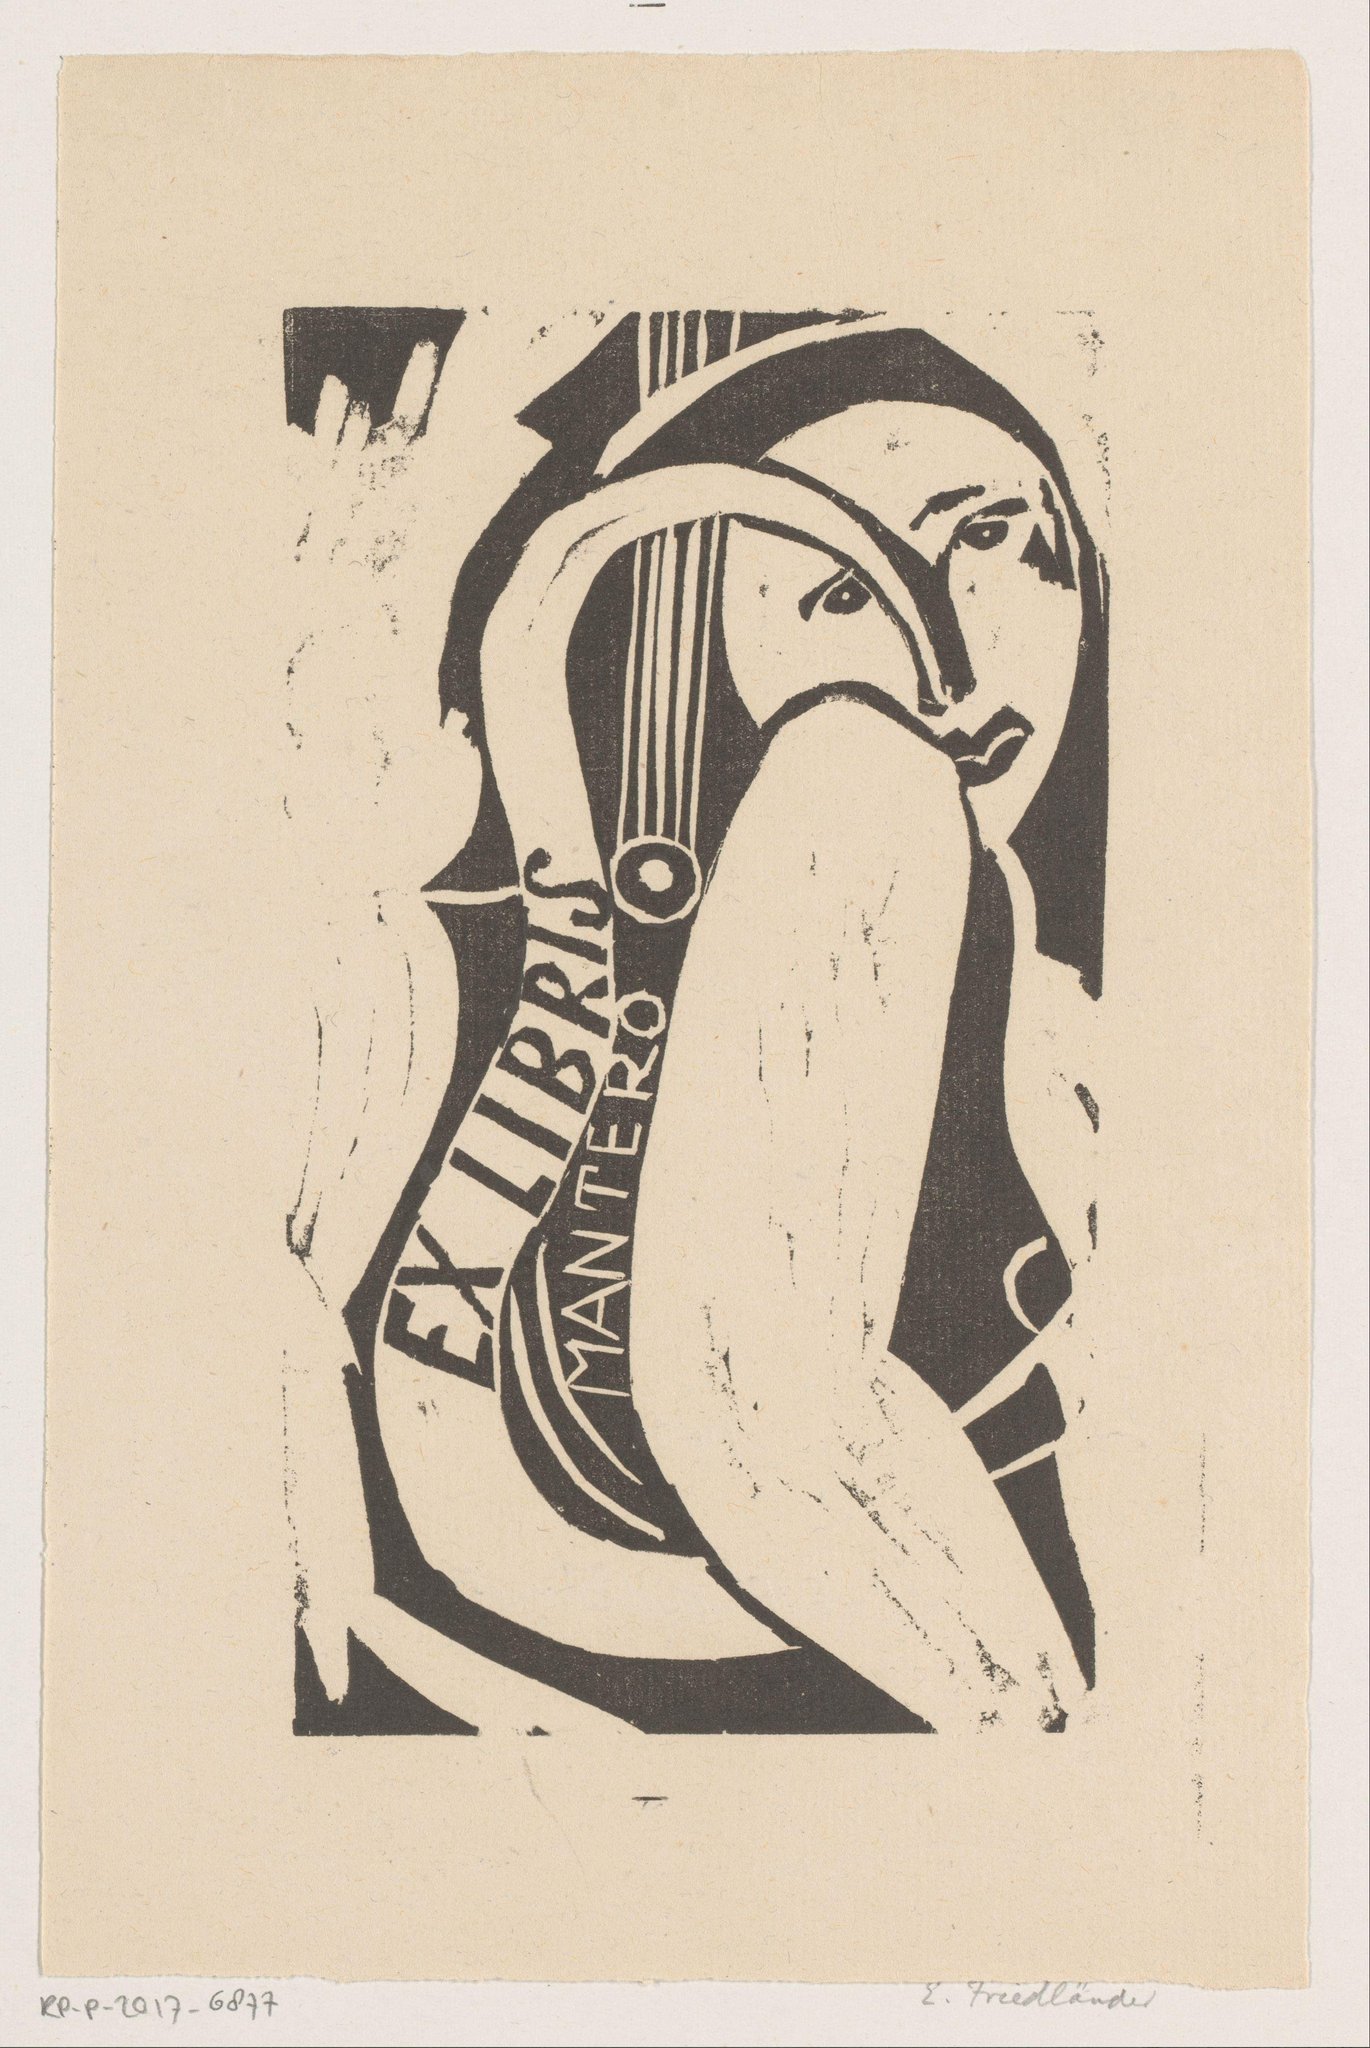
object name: bookplate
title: Ex libris van Gianni Mantero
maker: erna levy friedländer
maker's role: print maker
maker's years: 1890-1979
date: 1907-1985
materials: paper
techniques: woodcut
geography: germany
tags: gianni mantero, adult woman, cithern, mandolin, guitar, balalaika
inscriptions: inscription: ‘142/E. Friedländer’